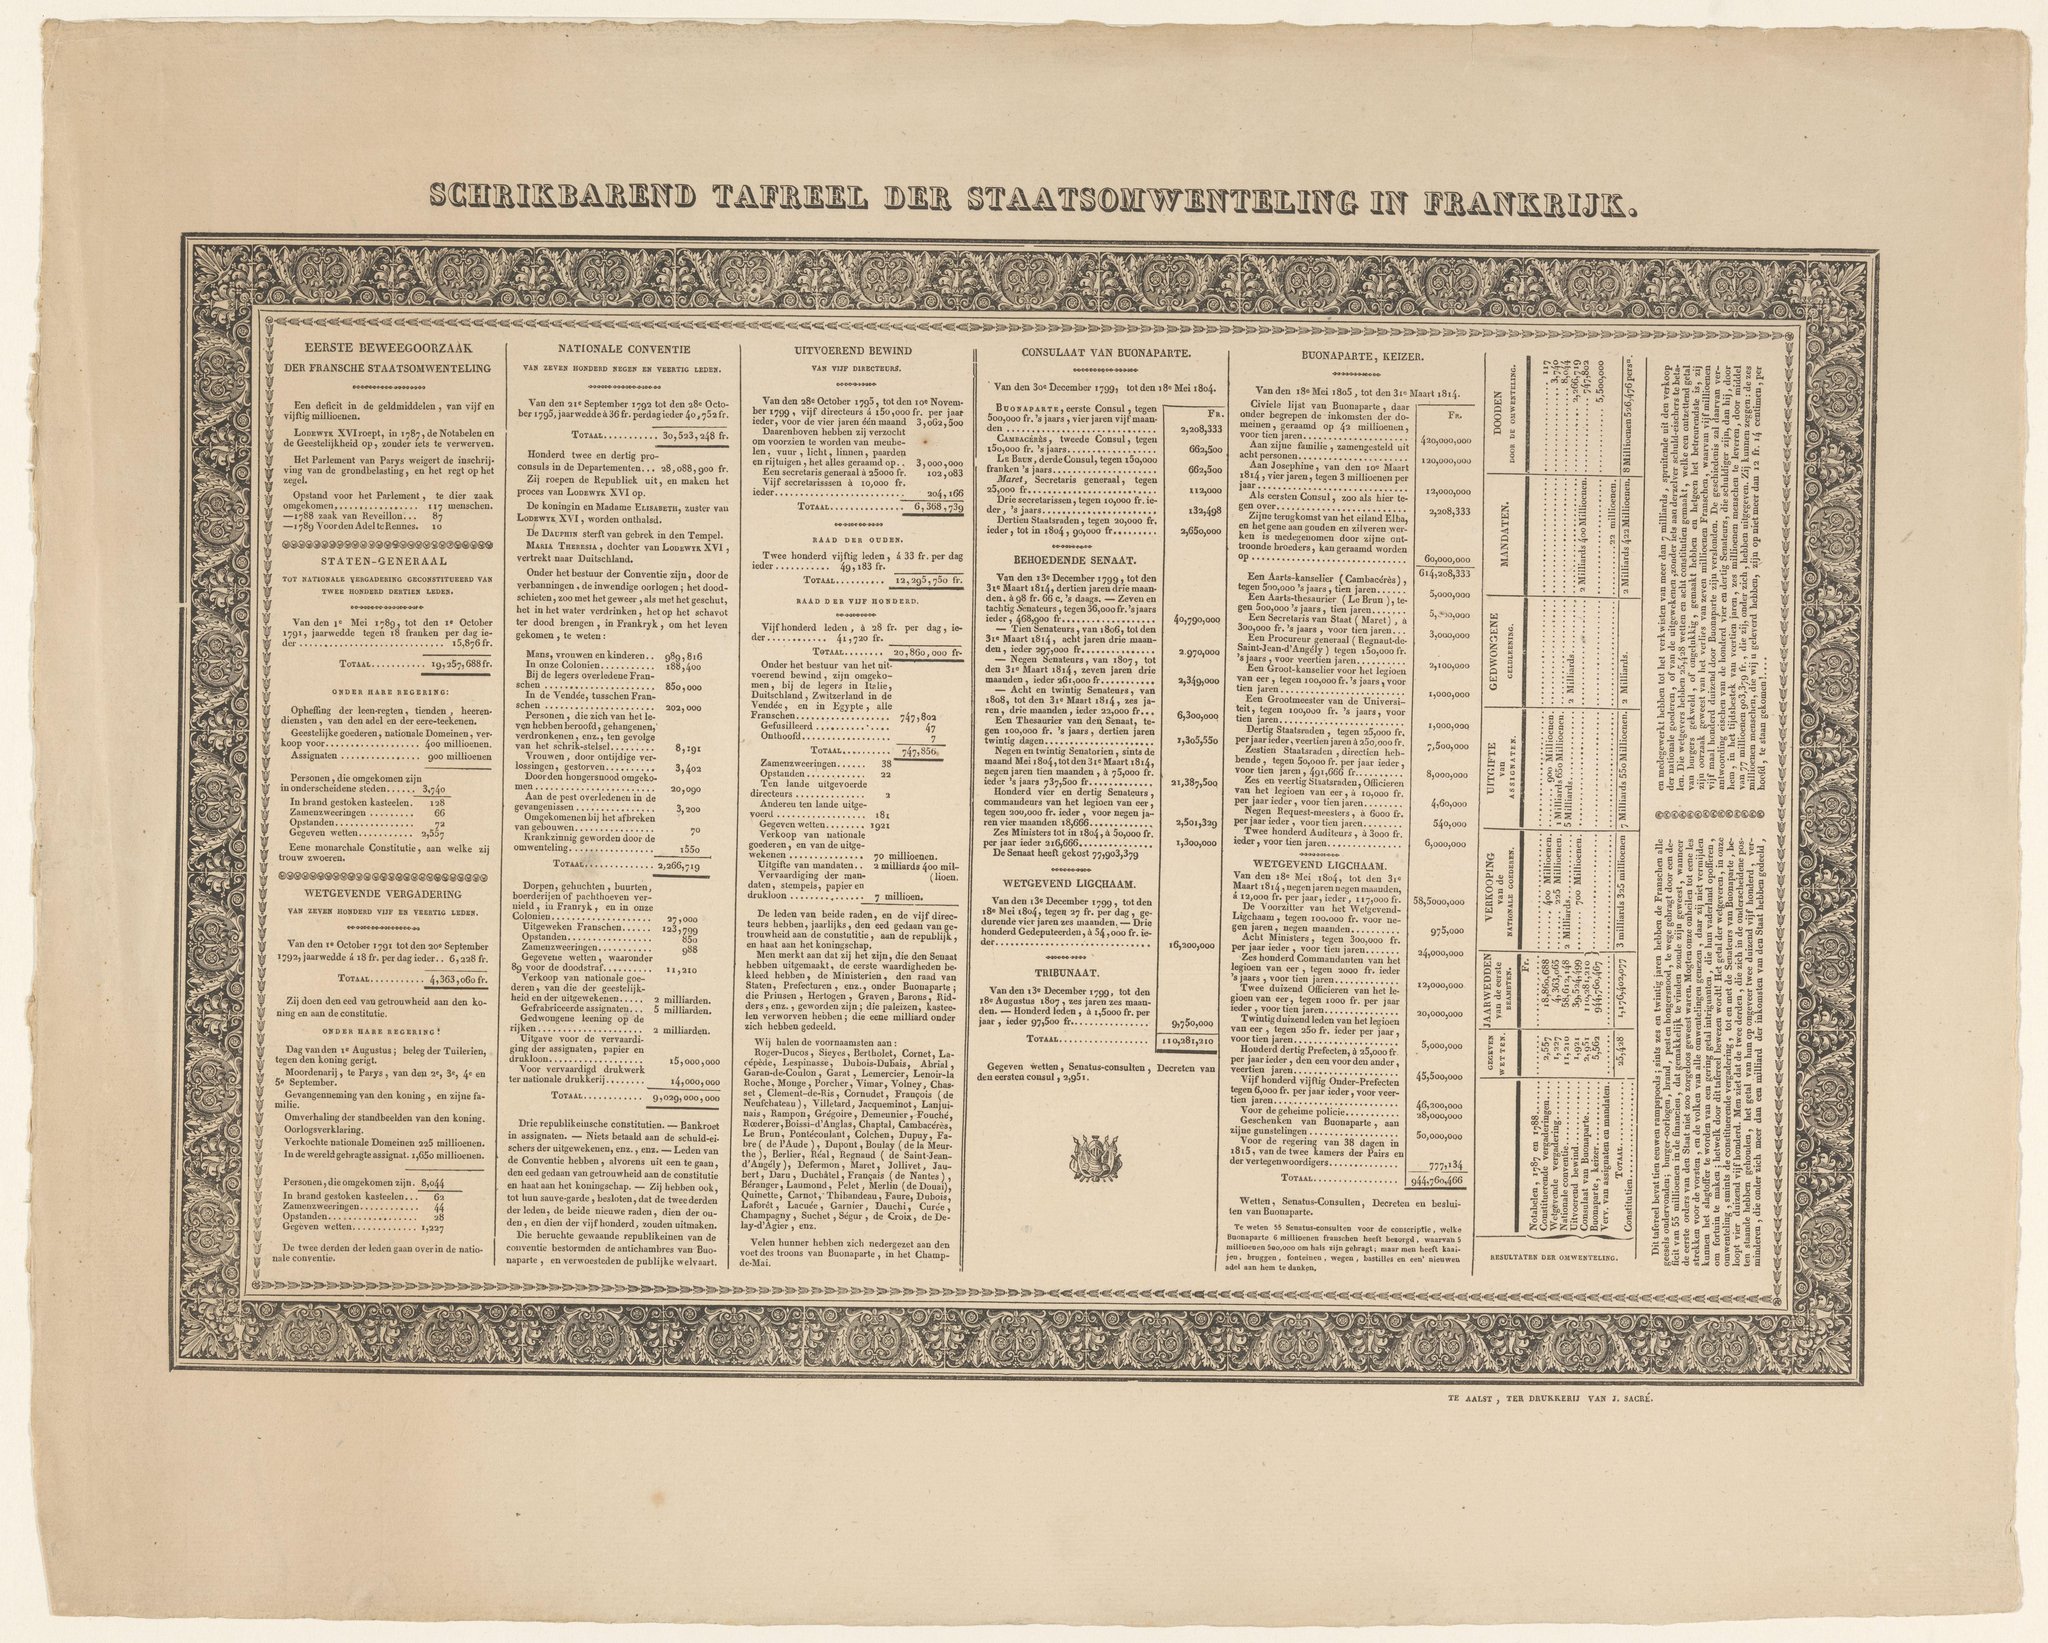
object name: print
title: Schrikbarend tafereel der staatsomwenteling in Frankrijk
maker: josse sacré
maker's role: publisher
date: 1814-1850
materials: paper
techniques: letterpress printing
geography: aalst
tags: franse revolutie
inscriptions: collector's mark: Lugt 2228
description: Tabellen van de financiële kosten van de Franse Revolutie, vanaf 1787 tot 1814.